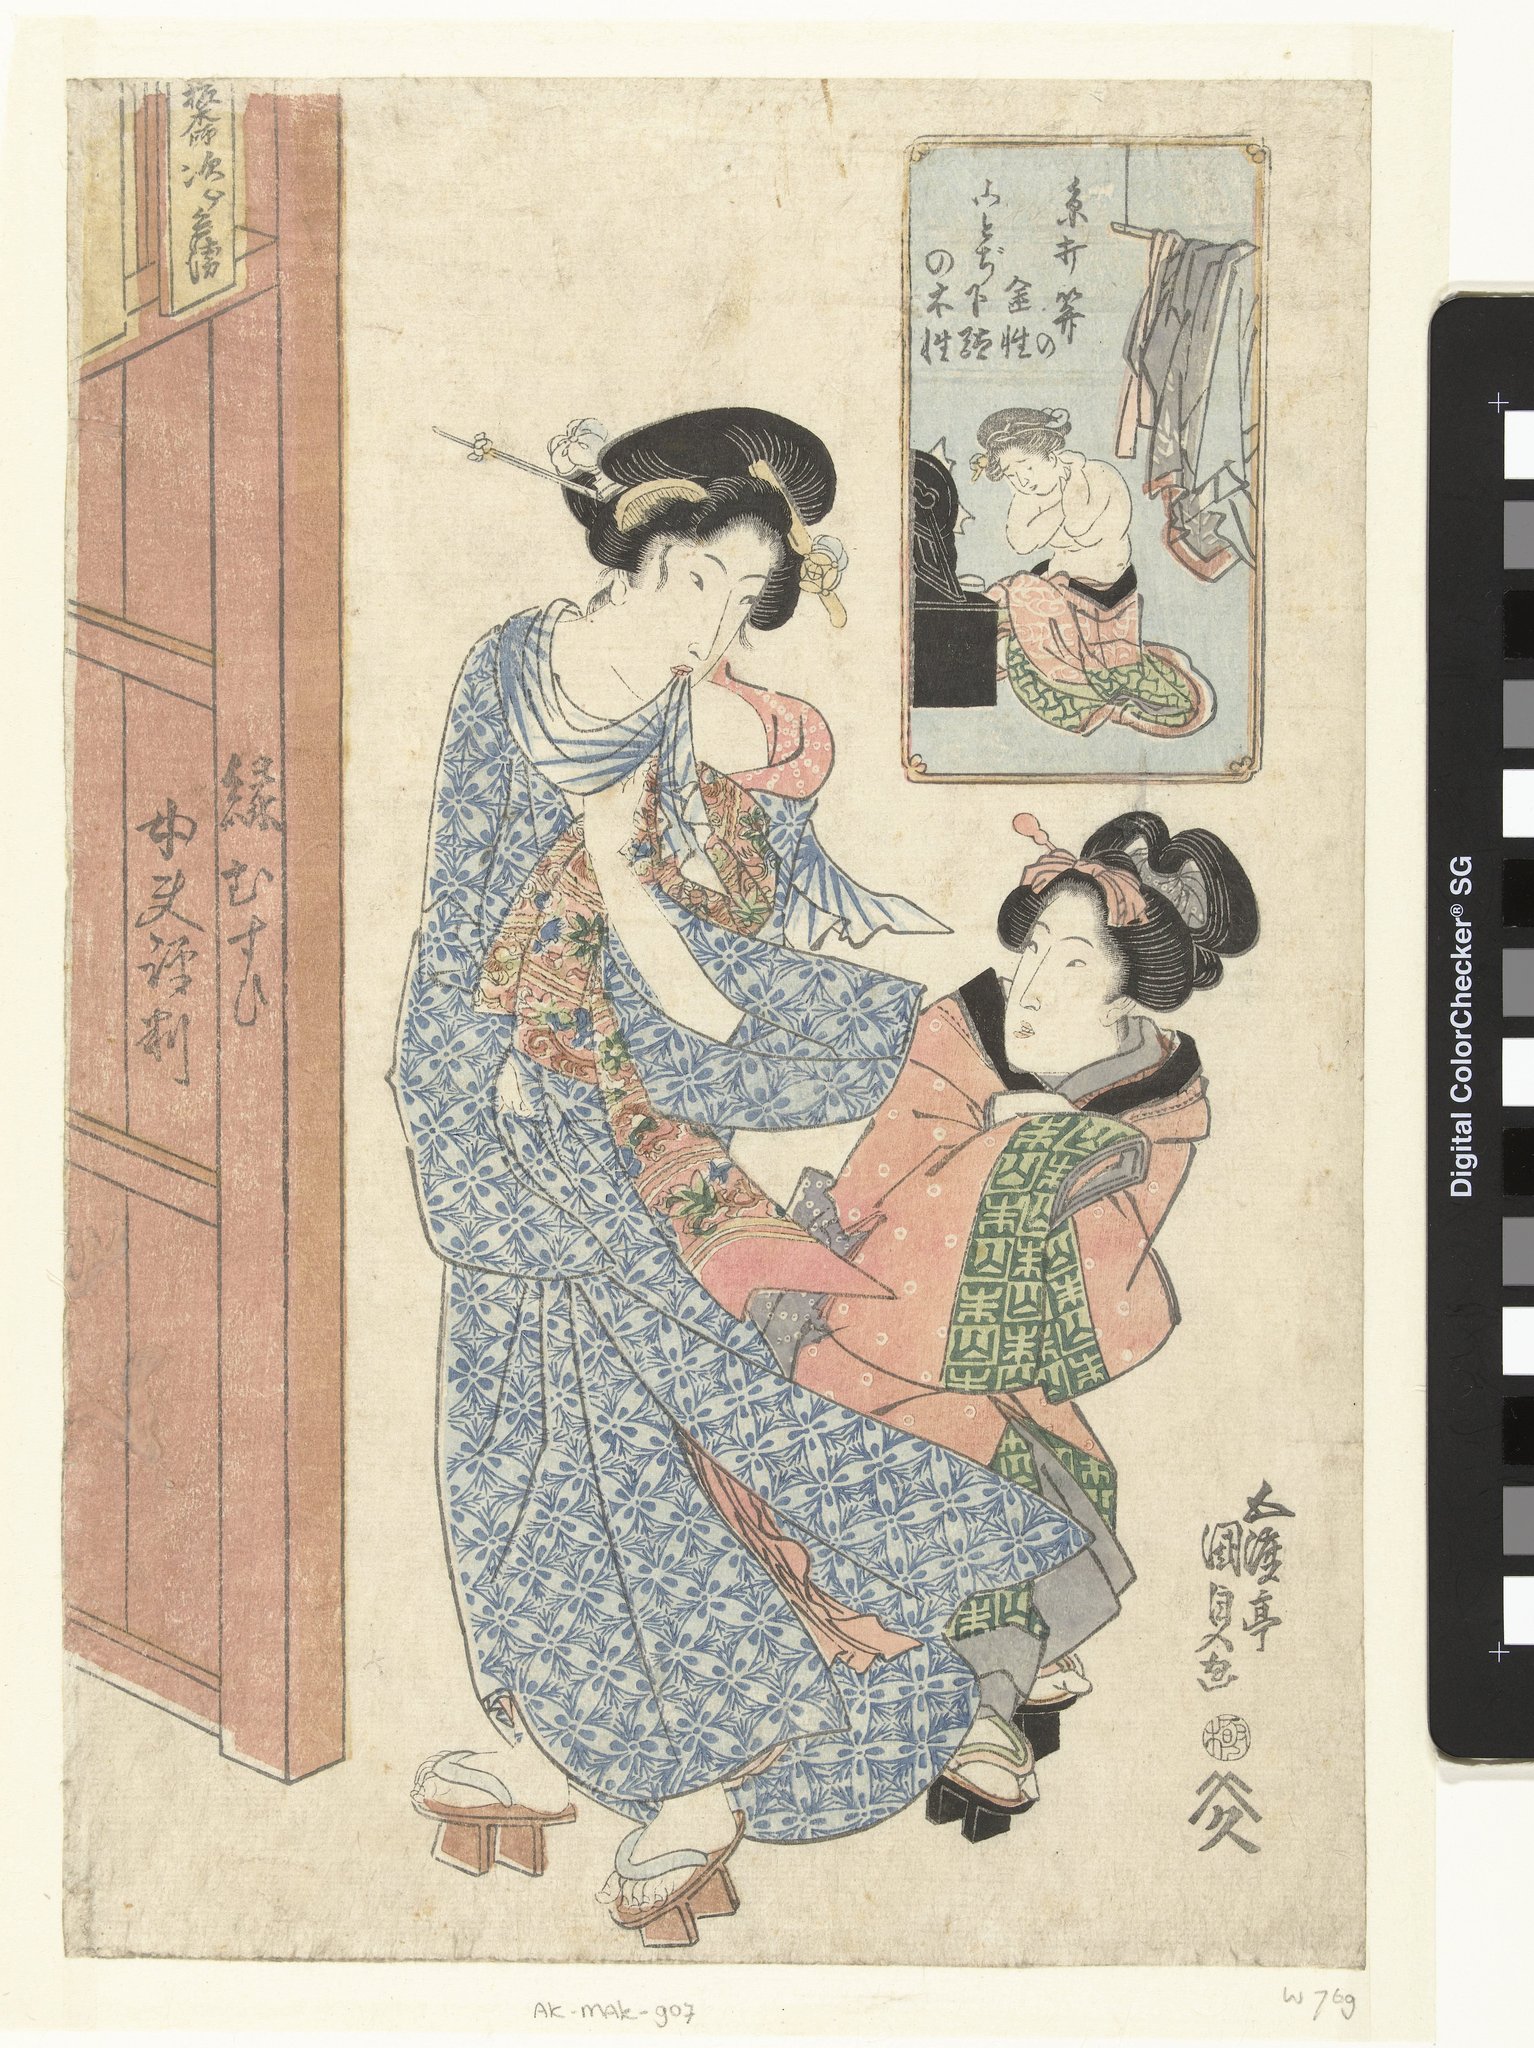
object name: print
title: The metal nature if the thread stitch, the wood nature of Kotojigeta (Itodasan no kinsei, Kotojigeta no mokusei).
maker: utagawa kunisada (i)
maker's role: print maker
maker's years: 1786-1865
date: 1825-1830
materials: paper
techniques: woodcut, nishiki e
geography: japan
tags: public baths